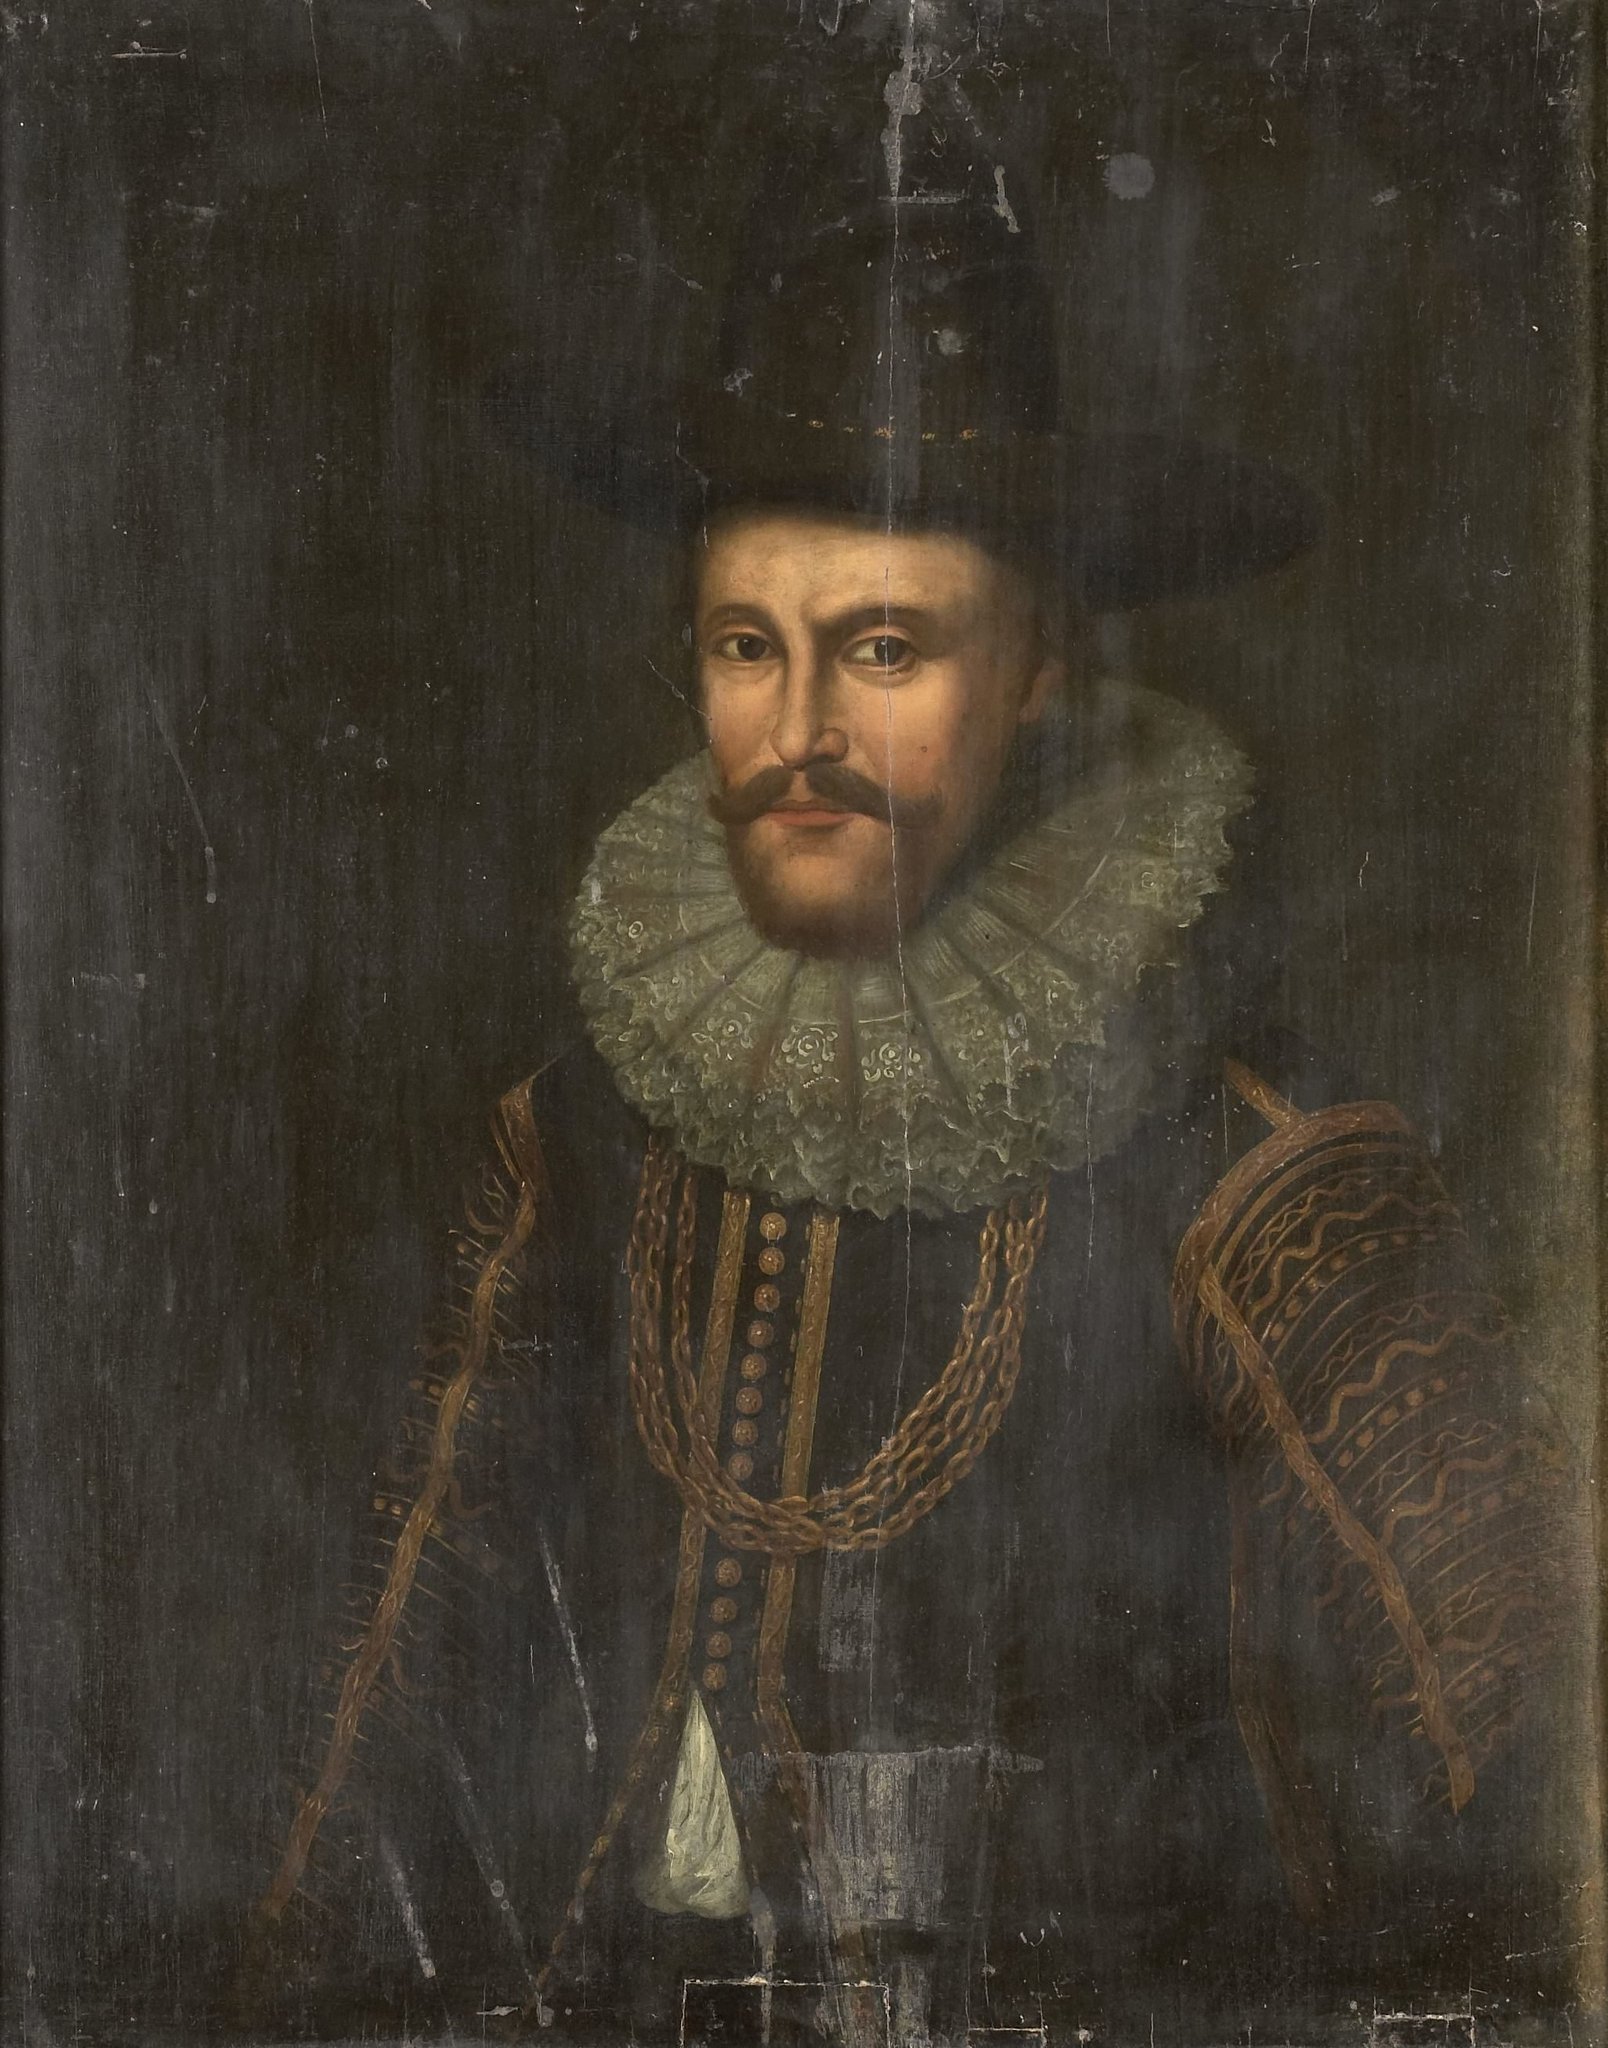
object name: painting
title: Portrait of Laurens Reael, Governor-General of the Dutch East Indies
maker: Anonymous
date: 1616-1675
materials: oil, panel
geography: netherlands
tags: laurens reael, colonial governor, historical persons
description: Portret van Laurens Reael (1583-1637). Gouverneur-generaal (1616-19). Ten halven lijve naar links. Om de hals een drievoudige gouden keten. Onderdeel van een reeks van portretten van de gouverneurs-generaal van het voormalige Nederlands Oost-Indië.